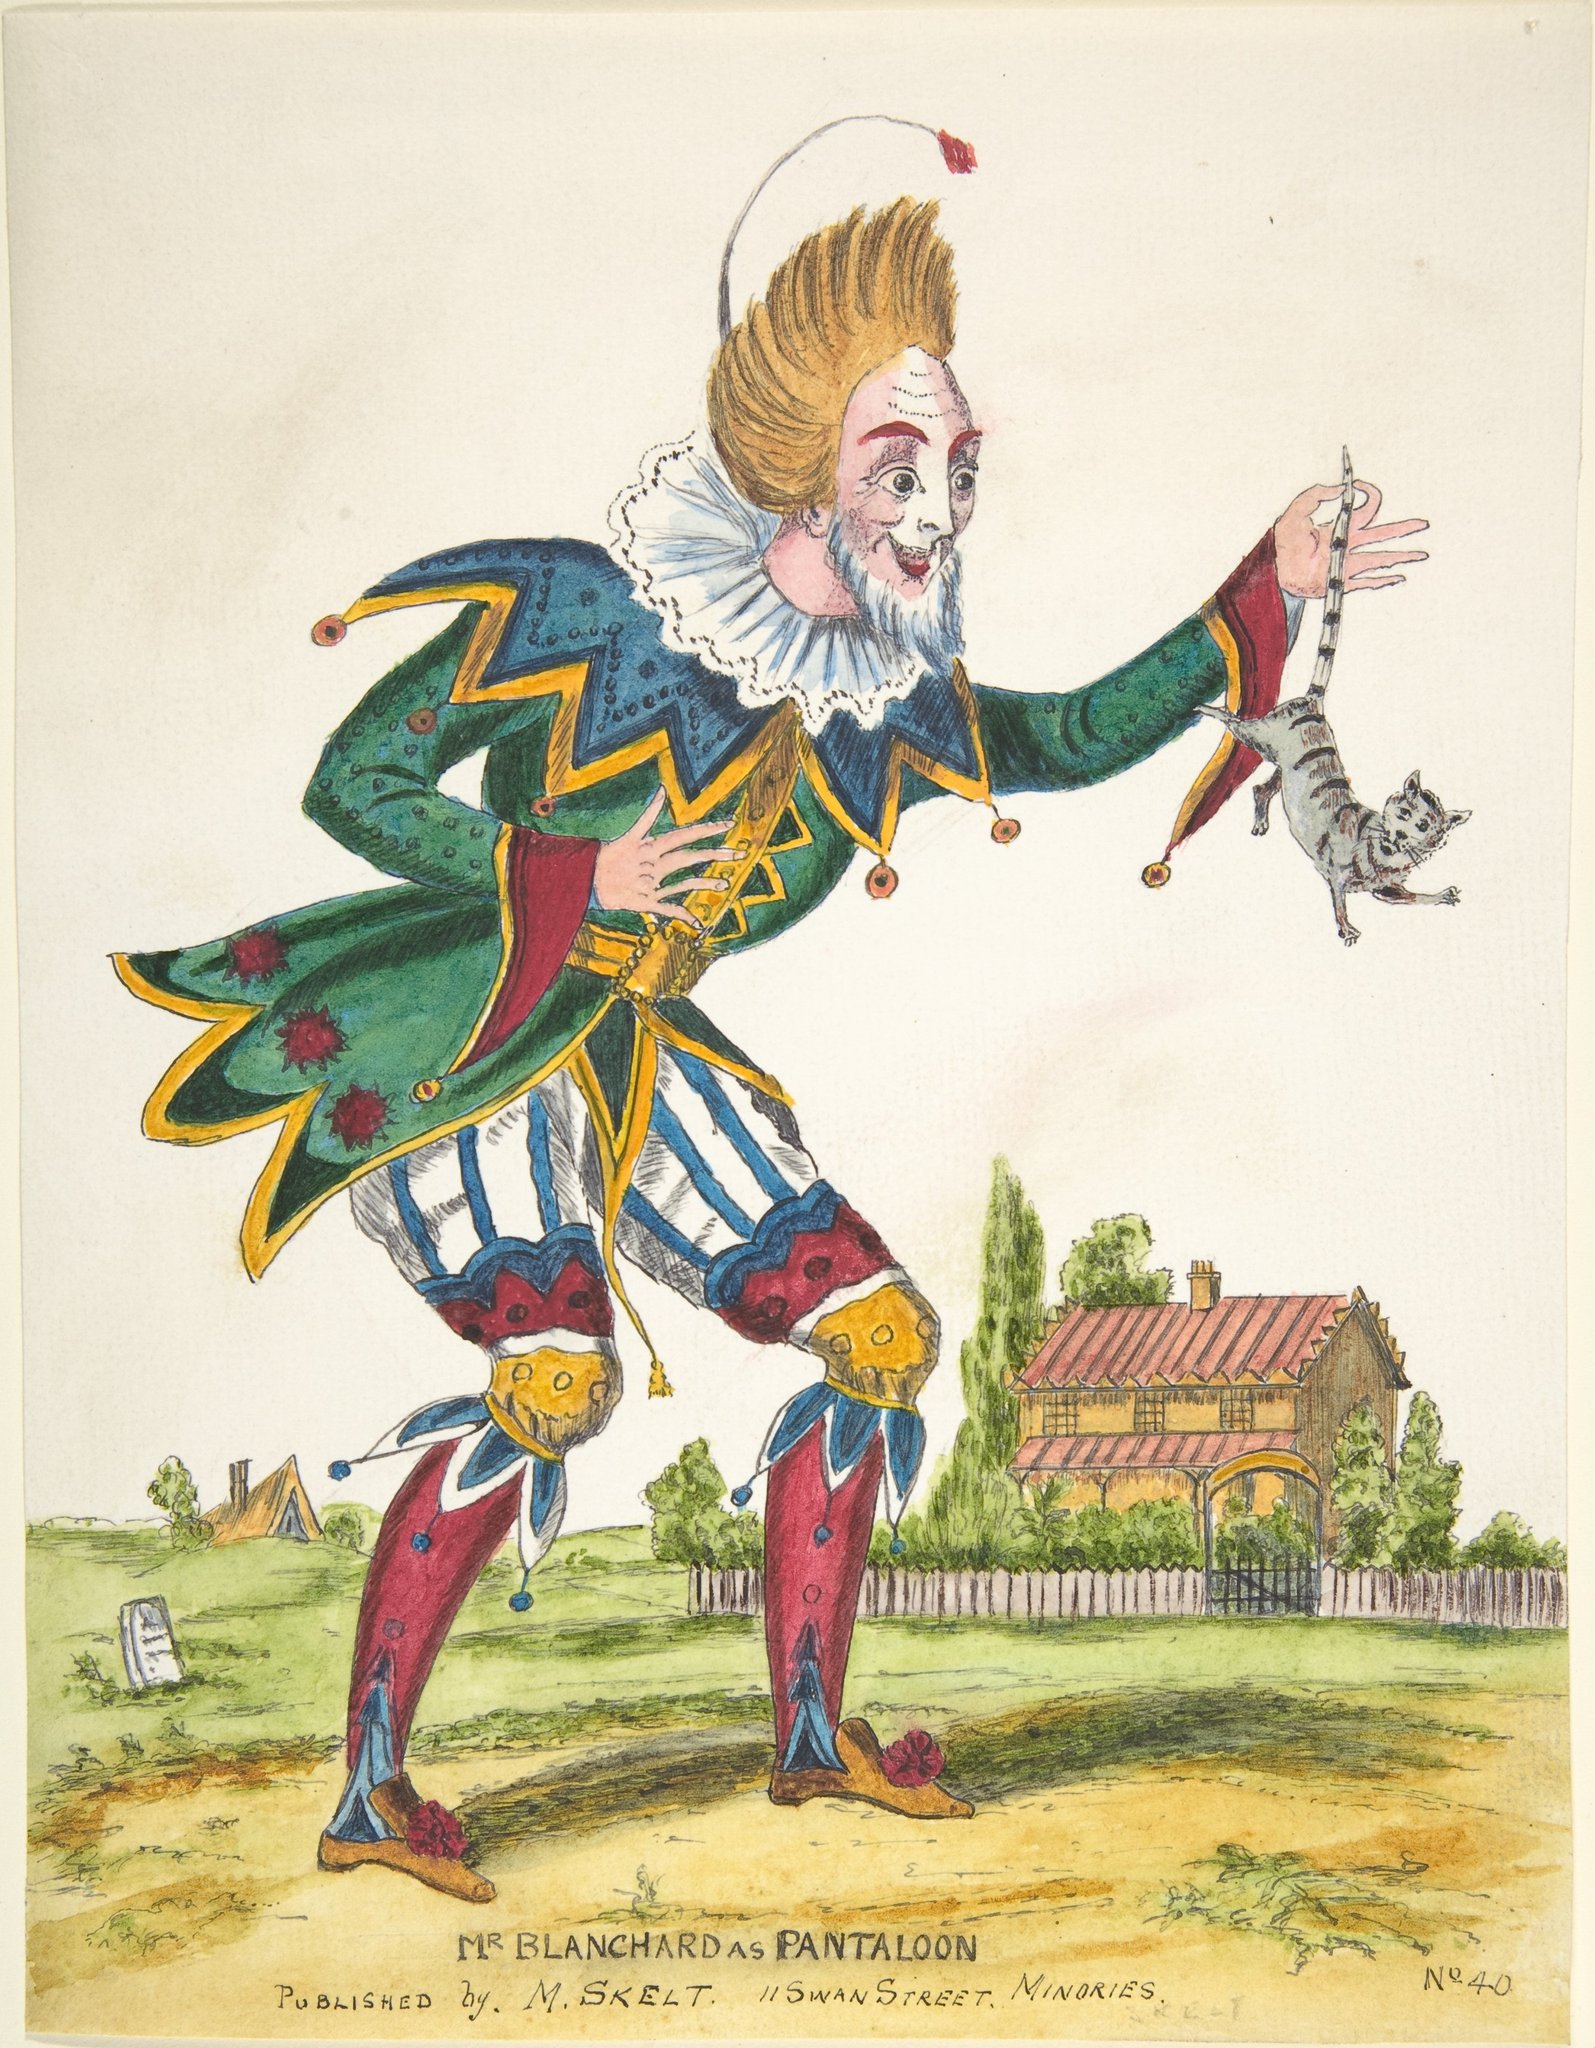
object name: drawing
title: Mr. Blanchard as Pantaloon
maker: anonymous, british, 19th century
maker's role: artist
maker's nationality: british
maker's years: 1800-1900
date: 1801-1900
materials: ink, watercolor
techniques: pen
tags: buildings,men,cats